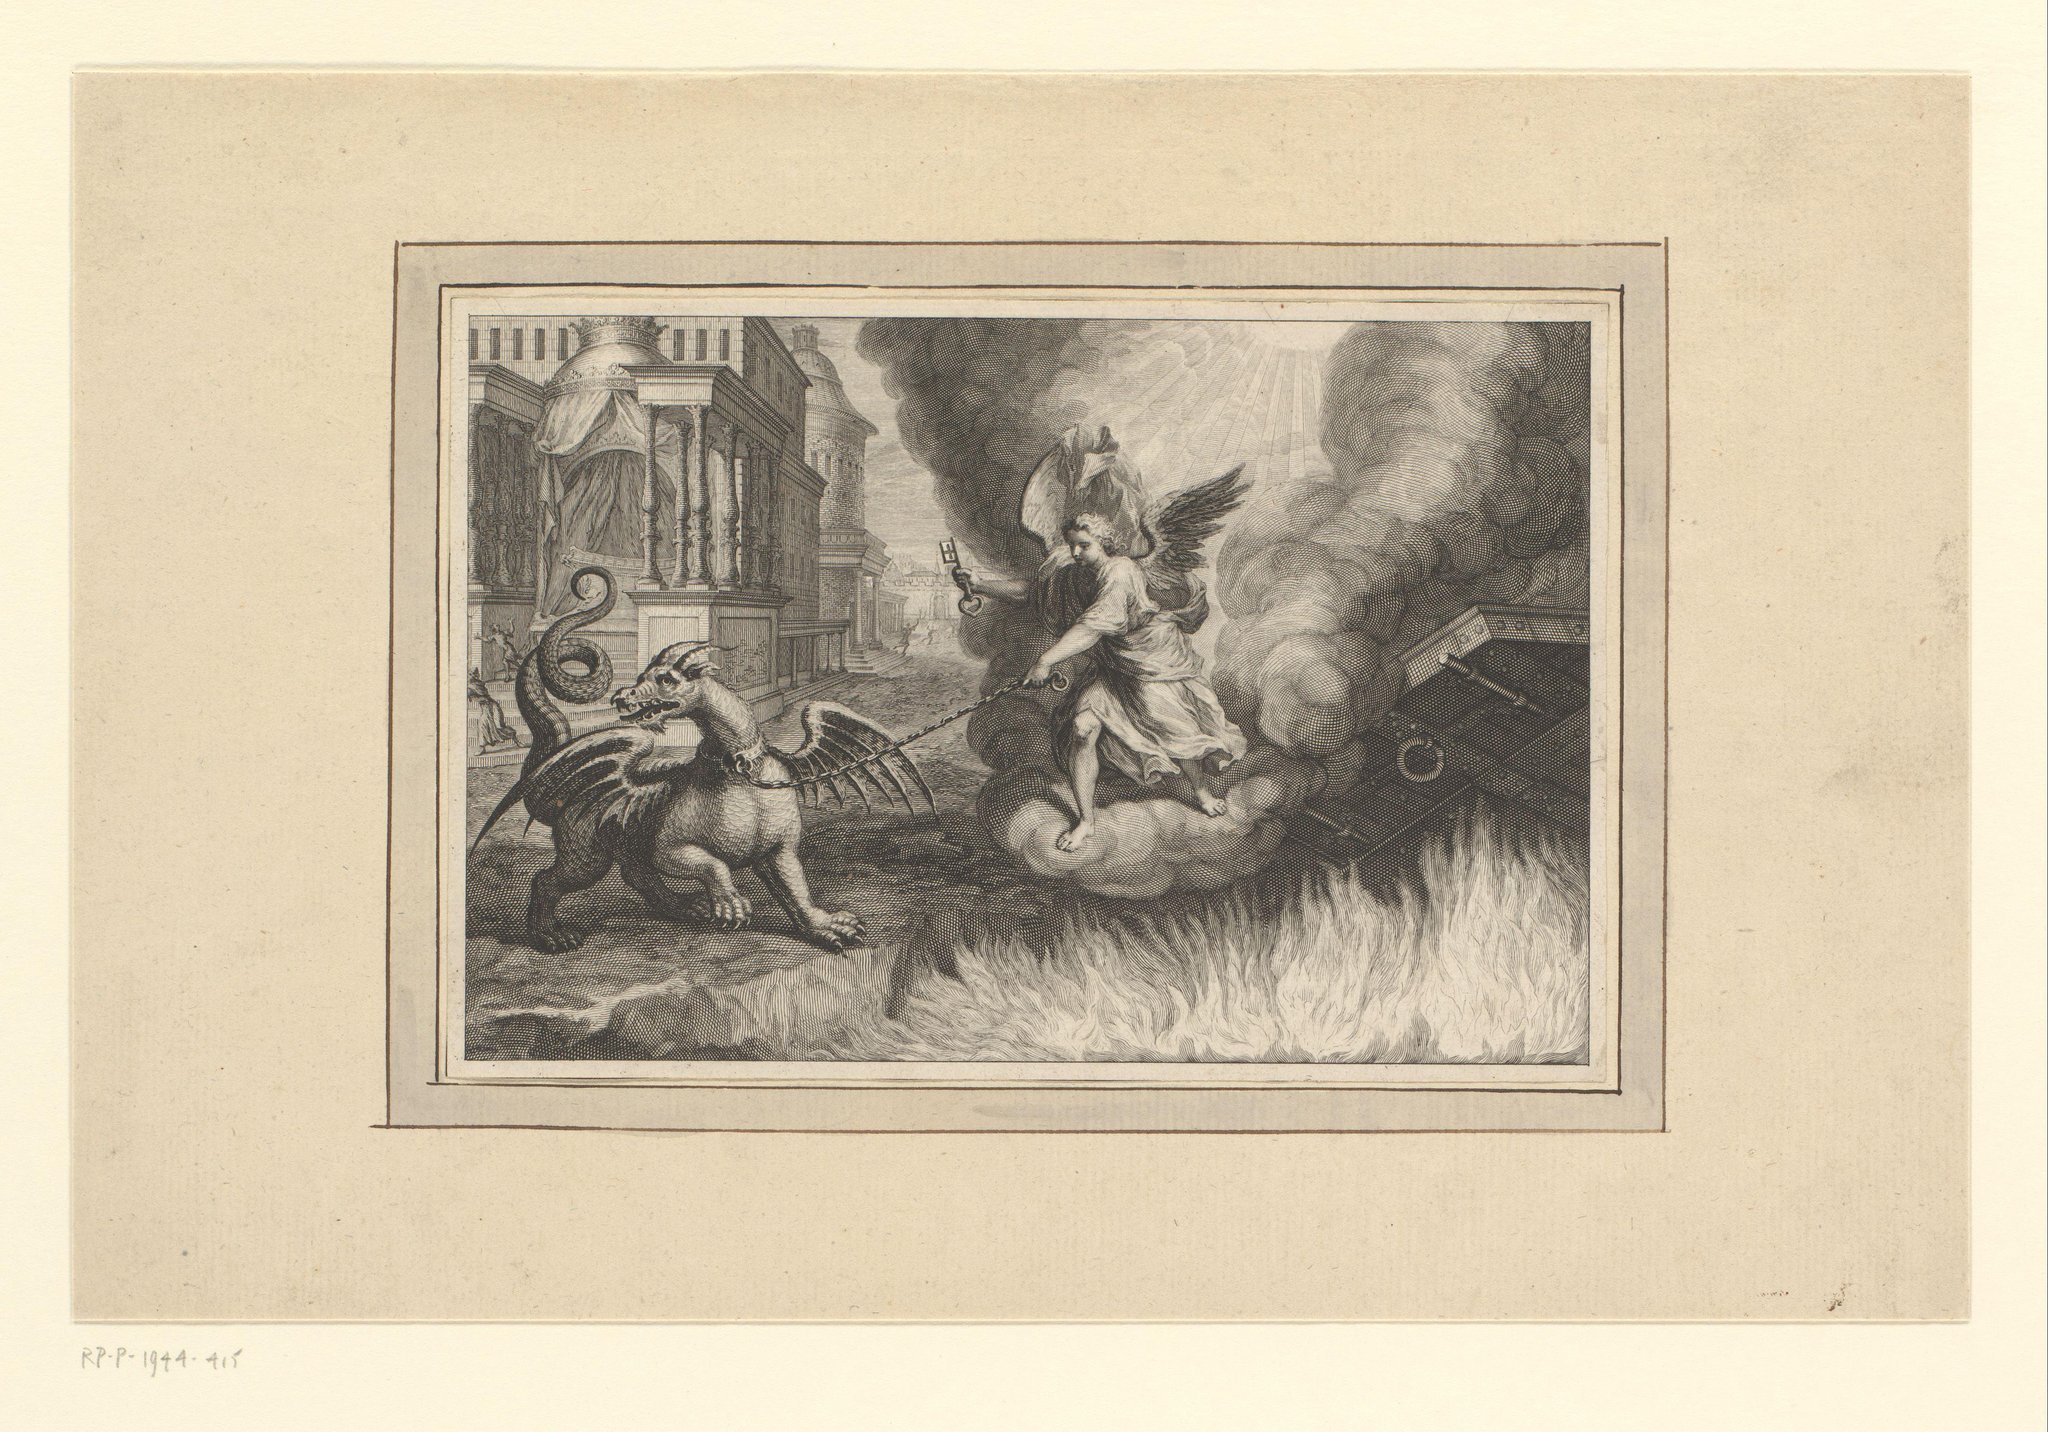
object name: print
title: Engel bedwingt een draak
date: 1600-1750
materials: paper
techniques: engraving, etching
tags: an angel with a key and a chain binds the dragon (satan) and casts him into the pit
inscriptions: collector's mark: Lugt 2228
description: Voorstelling uit Openbaring (Apoc. 19-22).